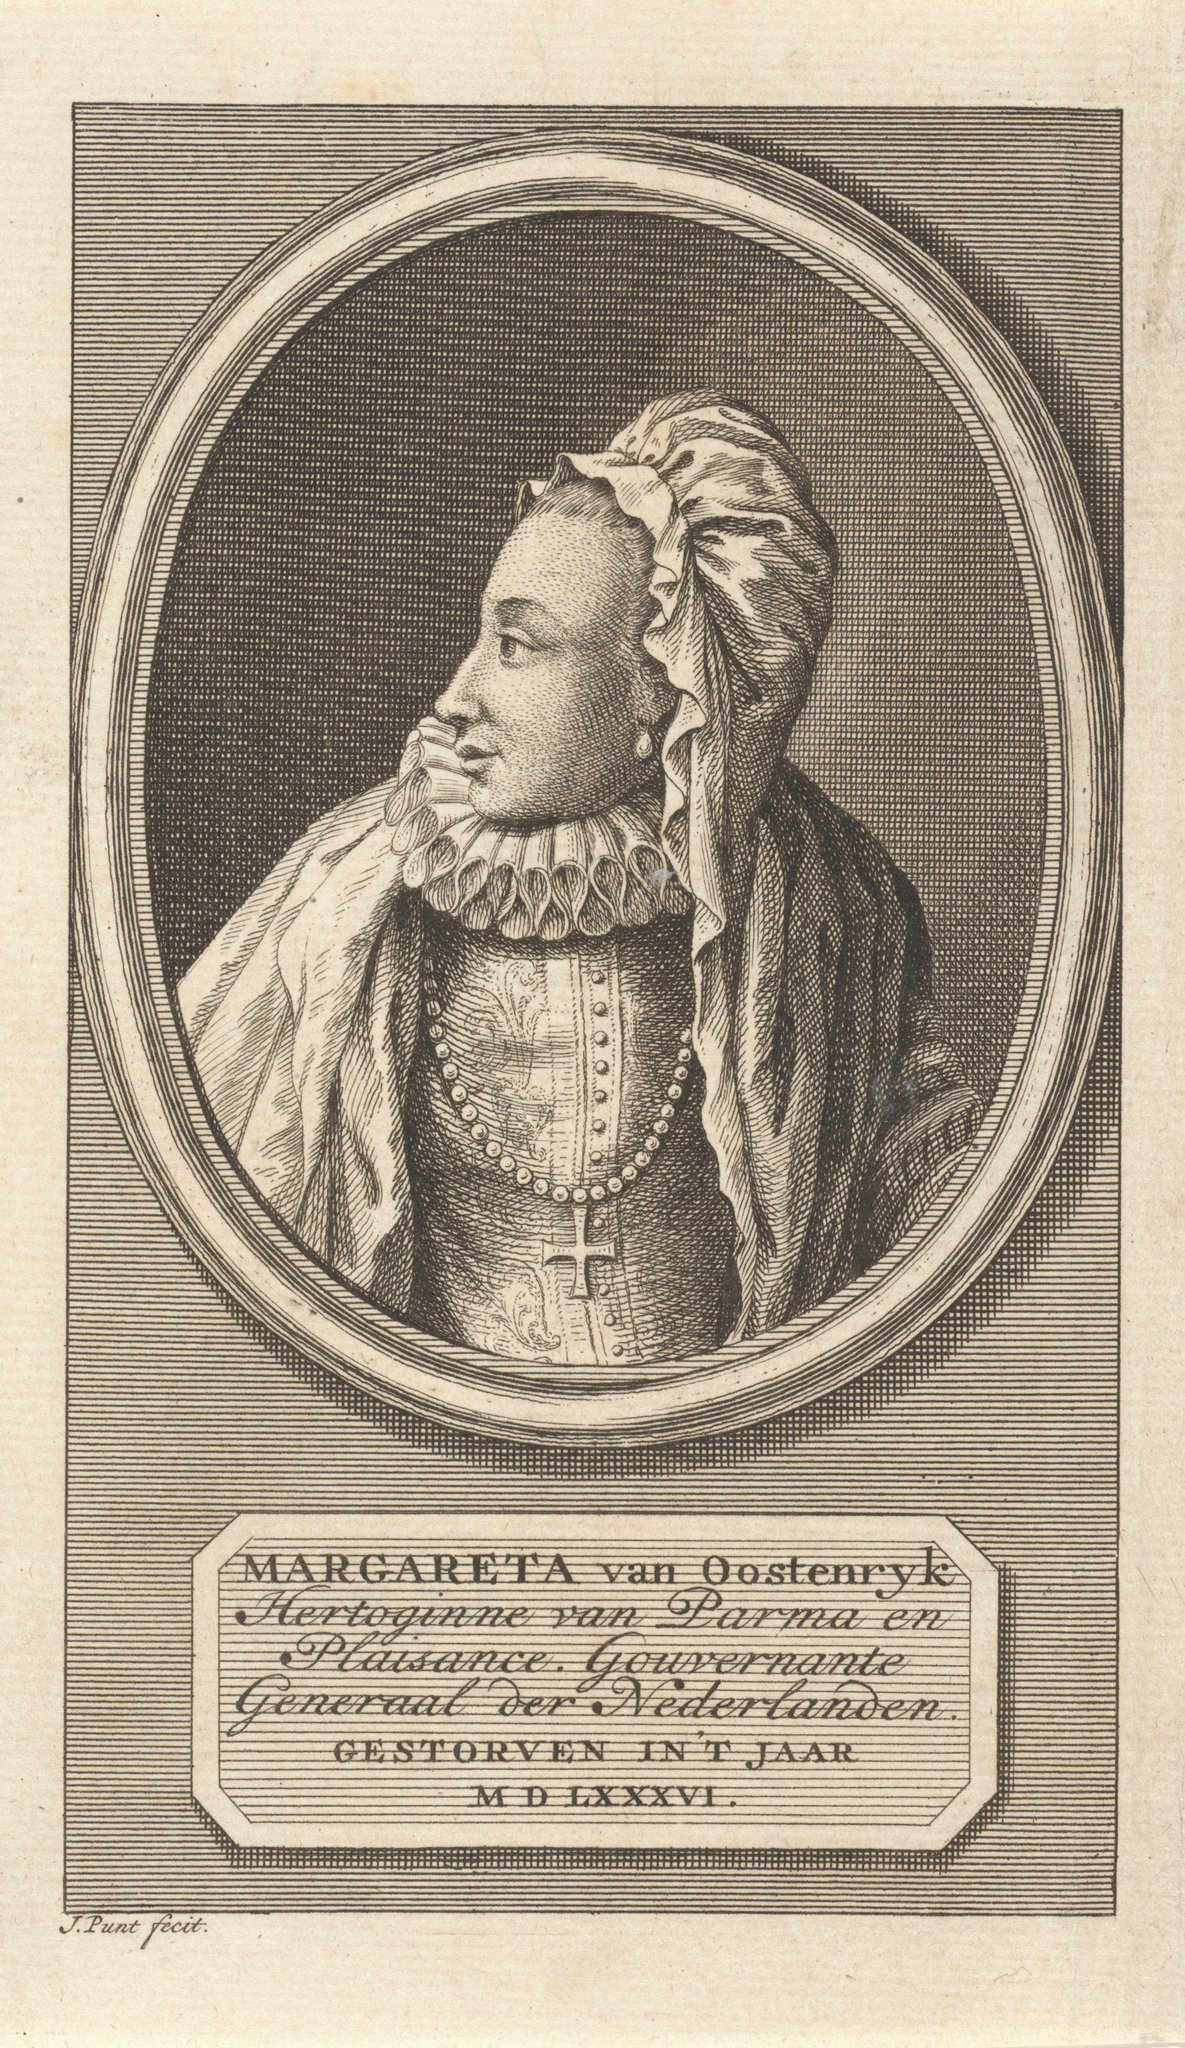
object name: print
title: Portret van Margaretha van Parma, landvoogdes der Nederlanden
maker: jan punt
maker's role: draughtsman, print maker, publisher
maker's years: 1711-1779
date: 1786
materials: paper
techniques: engraving, etching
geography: northern netherlands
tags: oudenaarde, ortona, landvoogd, landvoogdes der nederlanden margaretha van parma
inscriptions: collector's mark: Lugt 2228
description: Prent gebruikt als illustratie in: Meteren, Emanuel van. Oorlogen en geschiedenissen der Nederlanderen en derzelver nabuuren, deel I, p. 200. Amsterdam: Steven Jacobus Baalde, 1786.